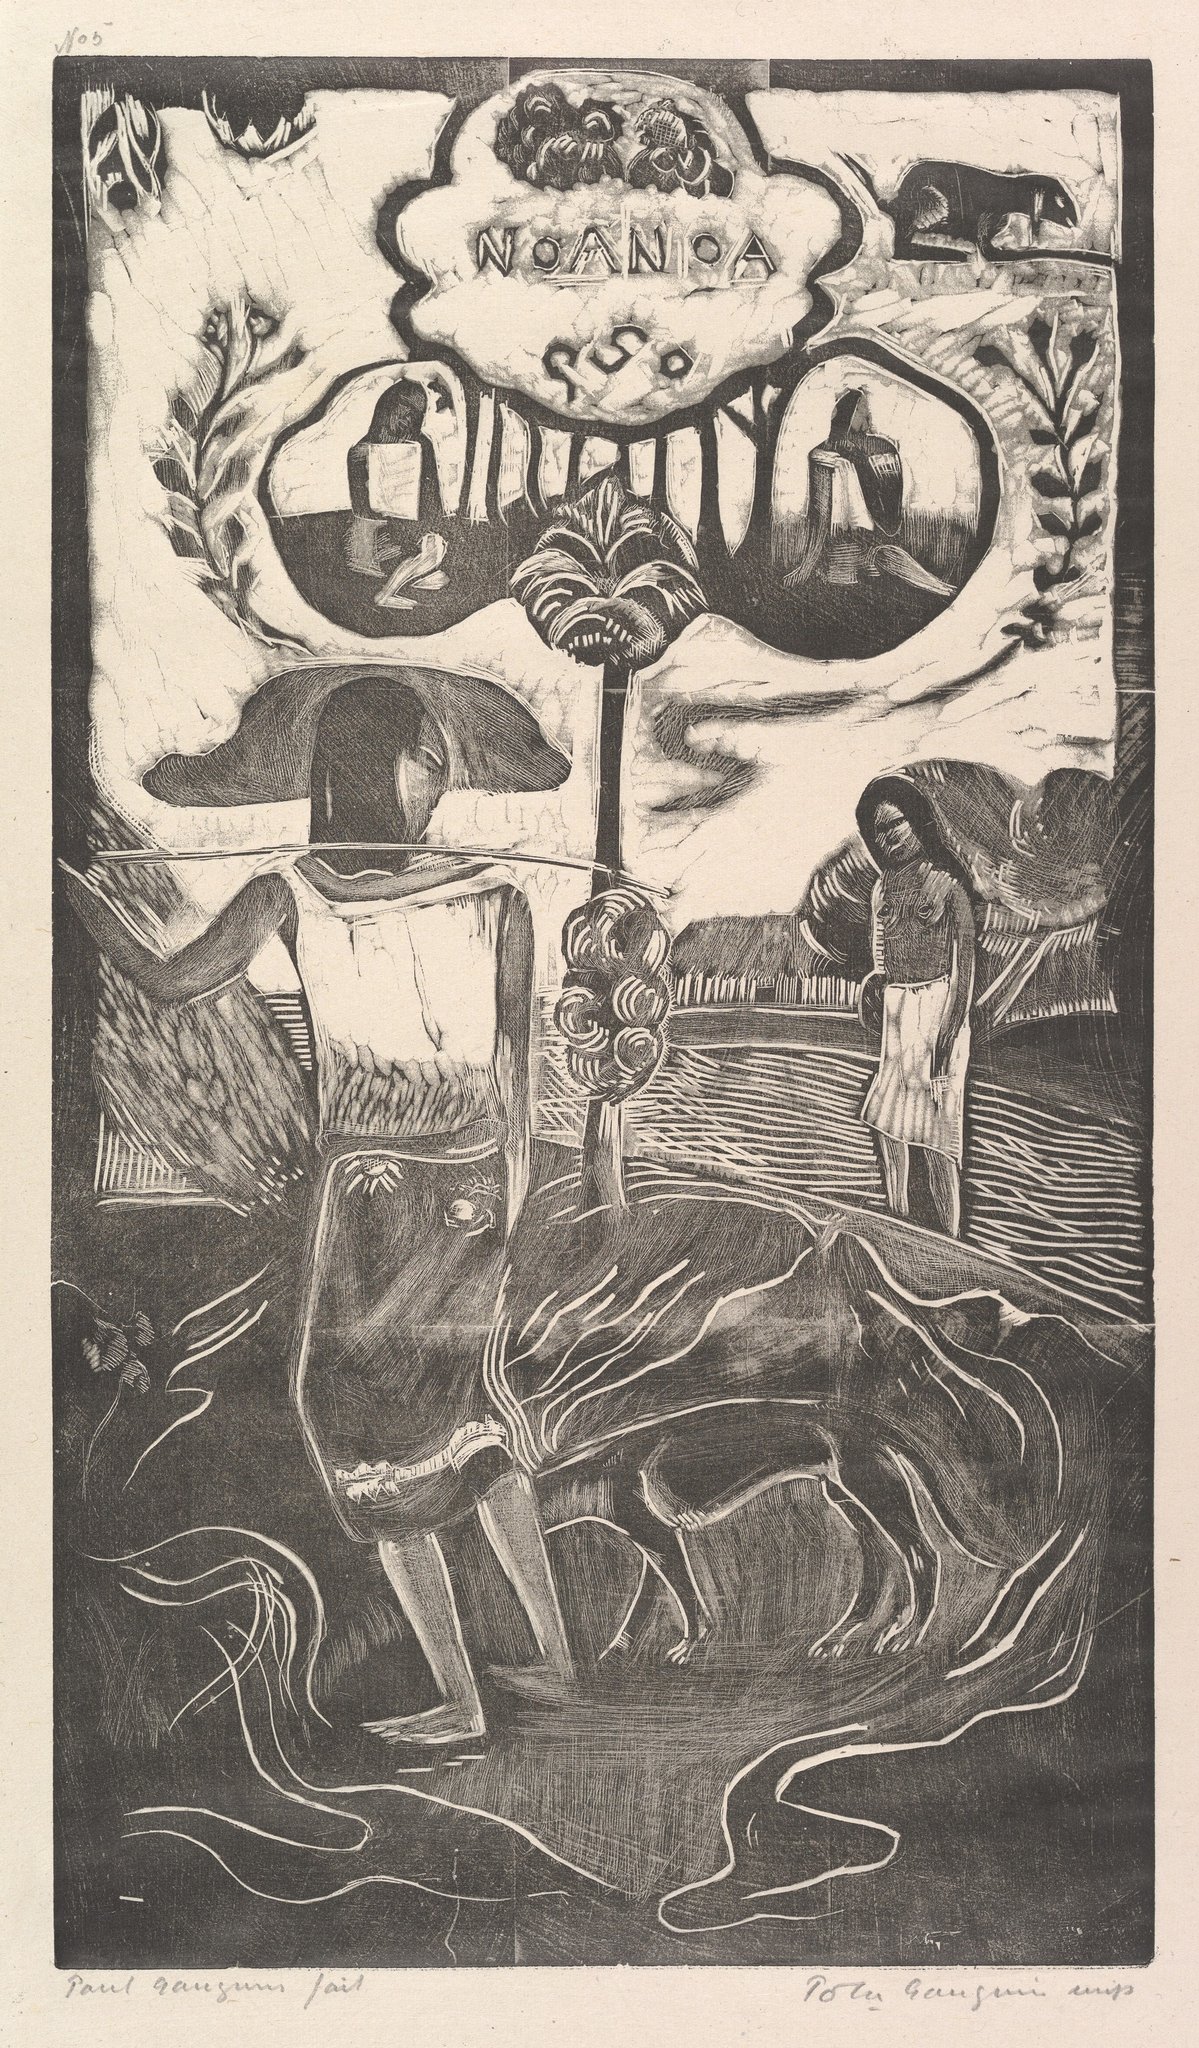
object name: print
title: Noa Noa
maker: paul gauguin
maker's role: artist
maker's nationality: french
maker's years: 1848-1903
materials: paper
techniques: woodcut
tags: human figures,animals